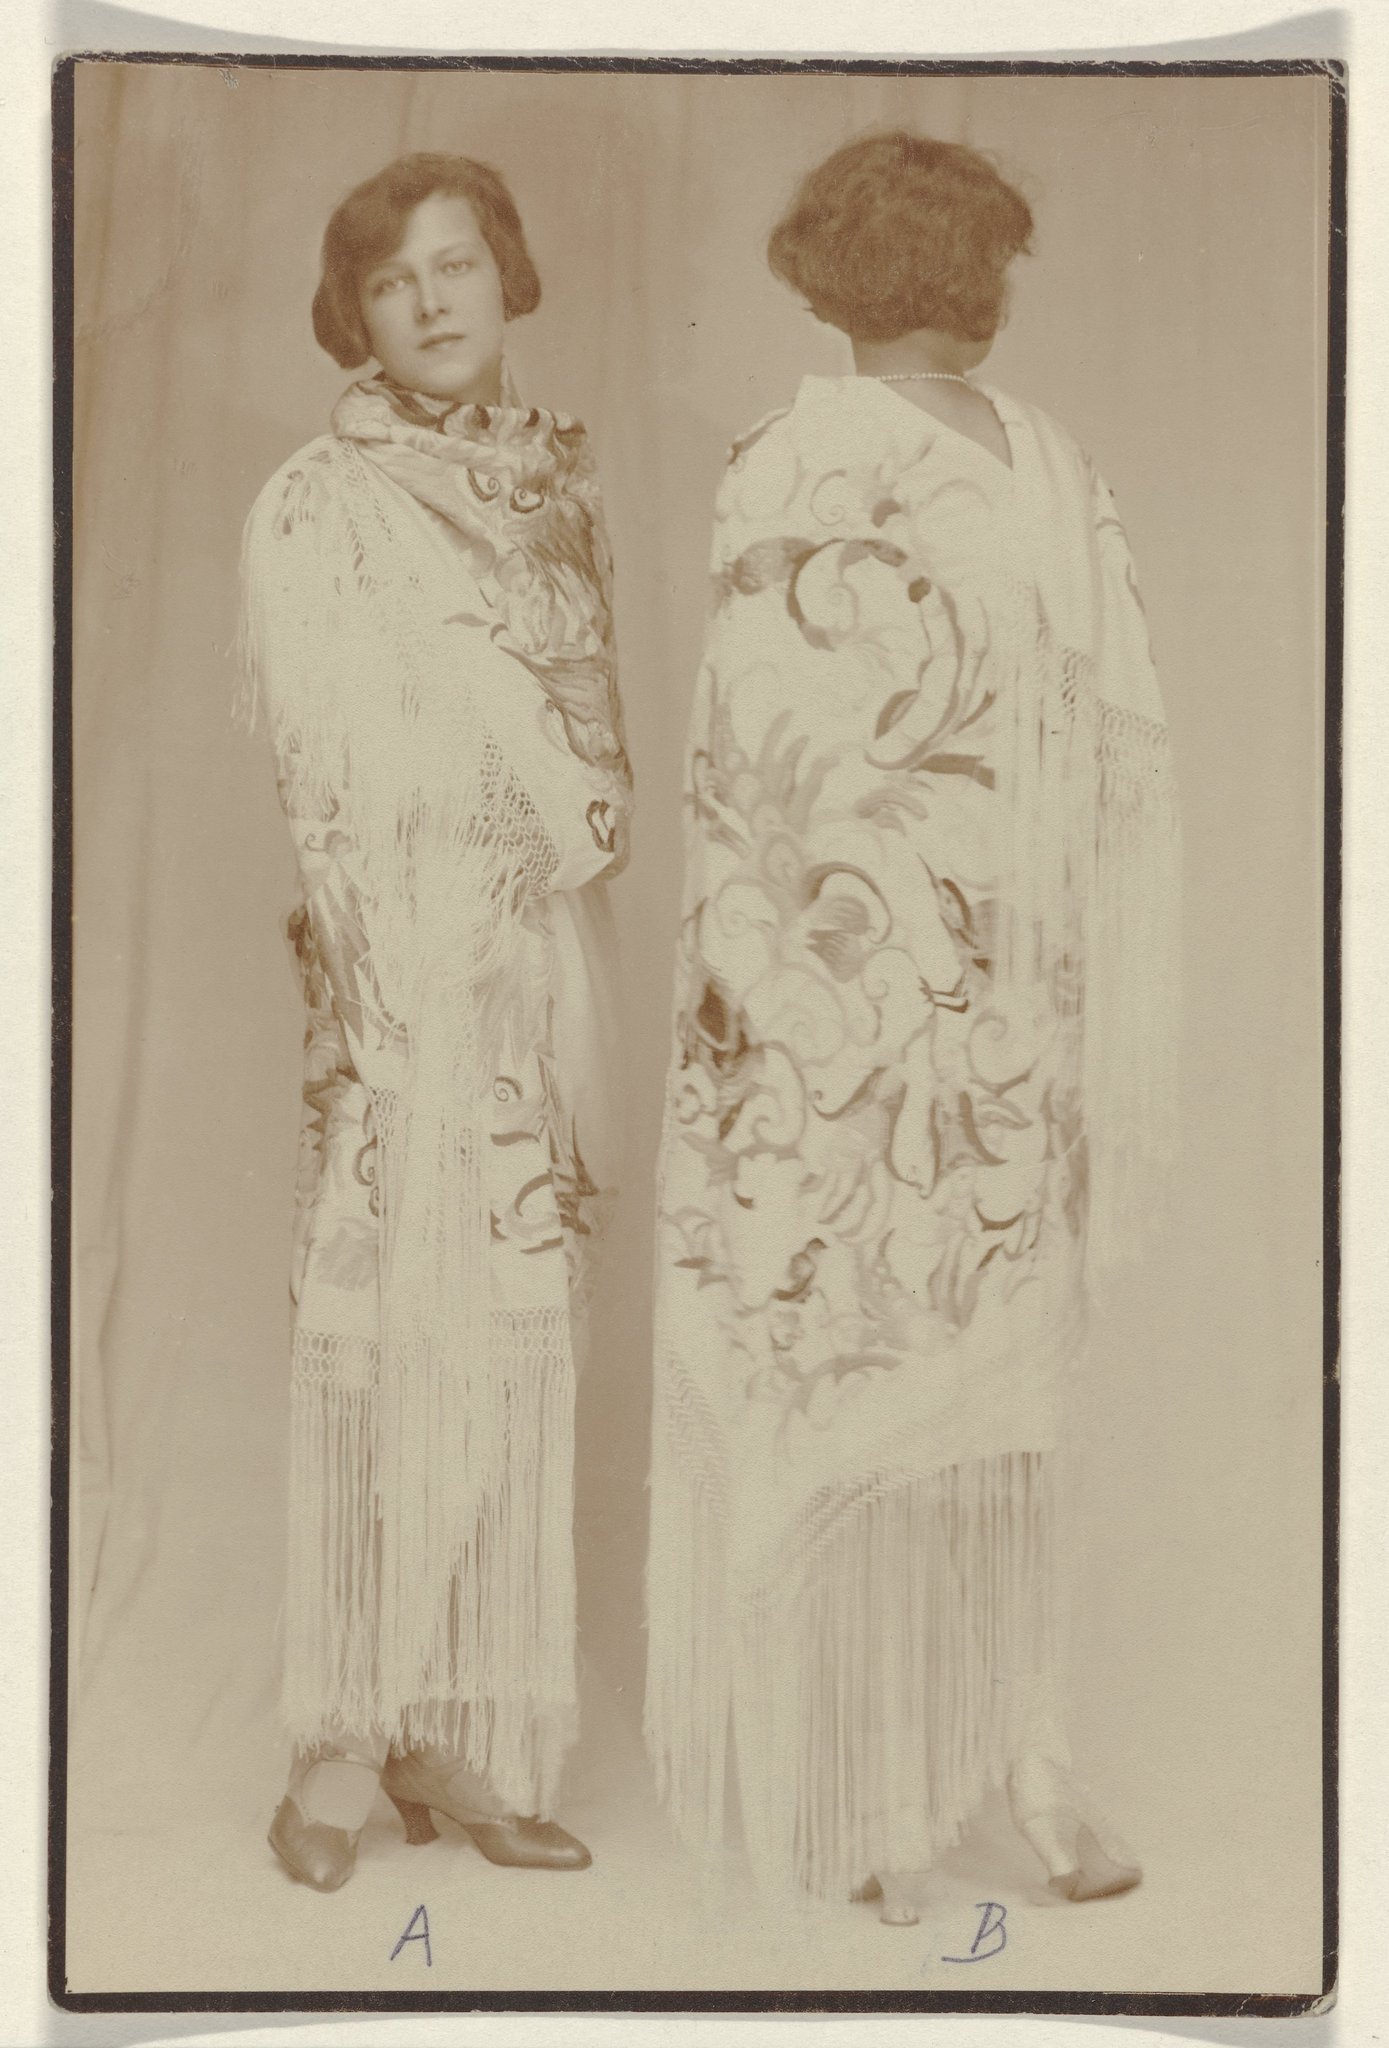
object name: photograph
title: Twee modellen met een geborduurde omslagdoek van de Wiener Werkstätte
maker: Anonymous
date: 1920-1930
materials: photographic support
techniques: gelatin silver print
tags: fashion plates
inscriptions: inscription